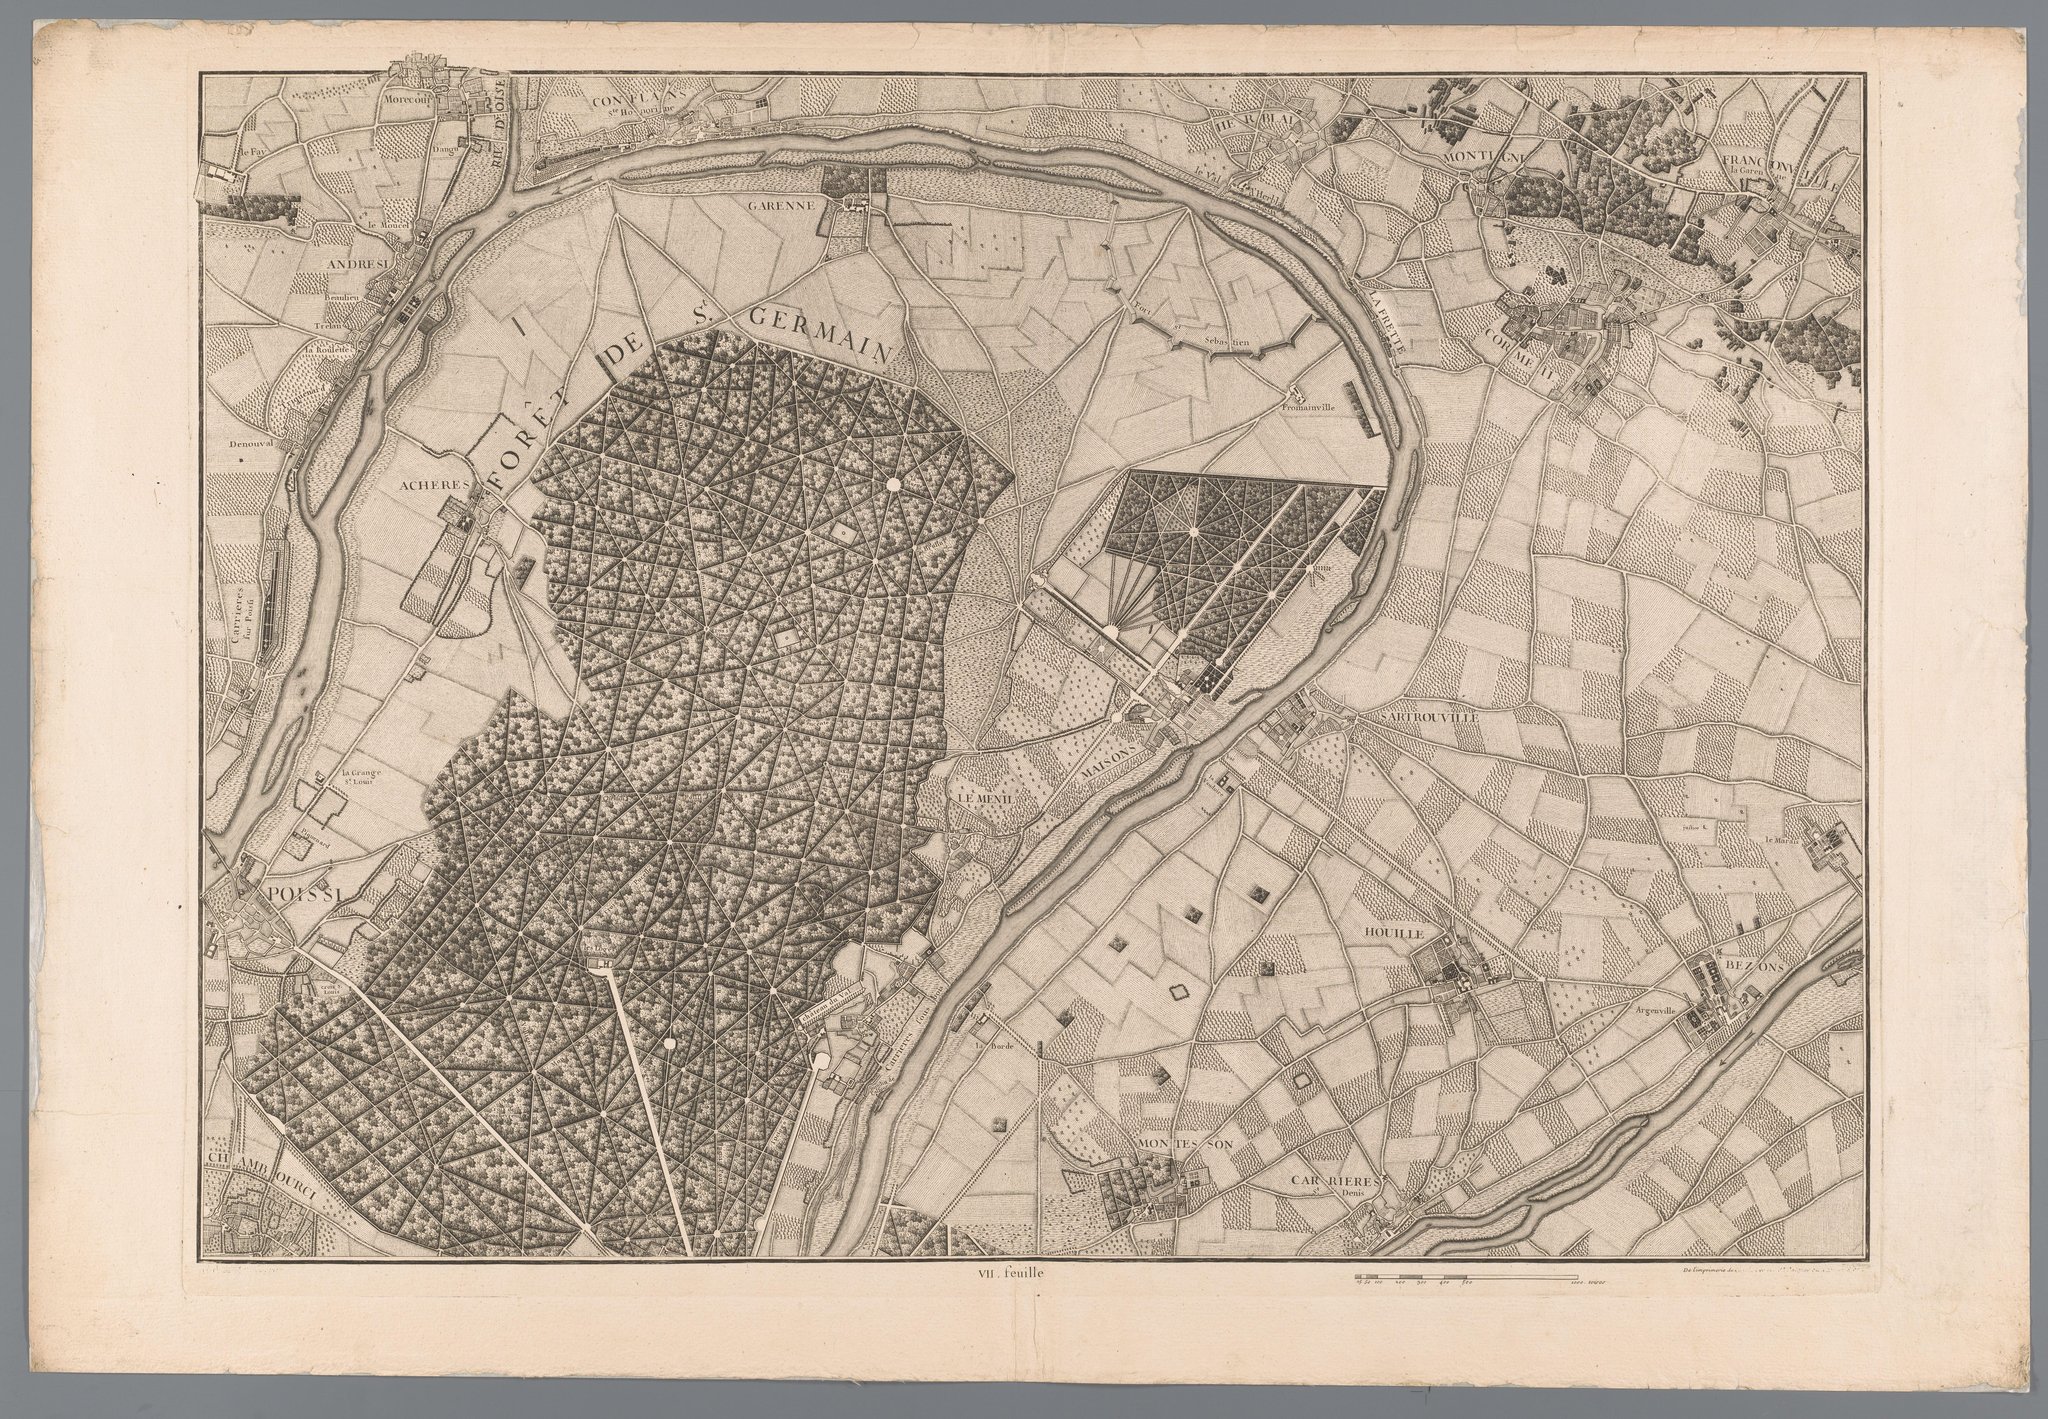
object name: print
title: VII feuille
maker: Anonymous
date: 1740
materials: paper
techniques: engraving, etching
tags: plan, map of garden, maps of cities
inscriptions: collector's mark: Lugt 2228, collector's mark: Lugt 2760